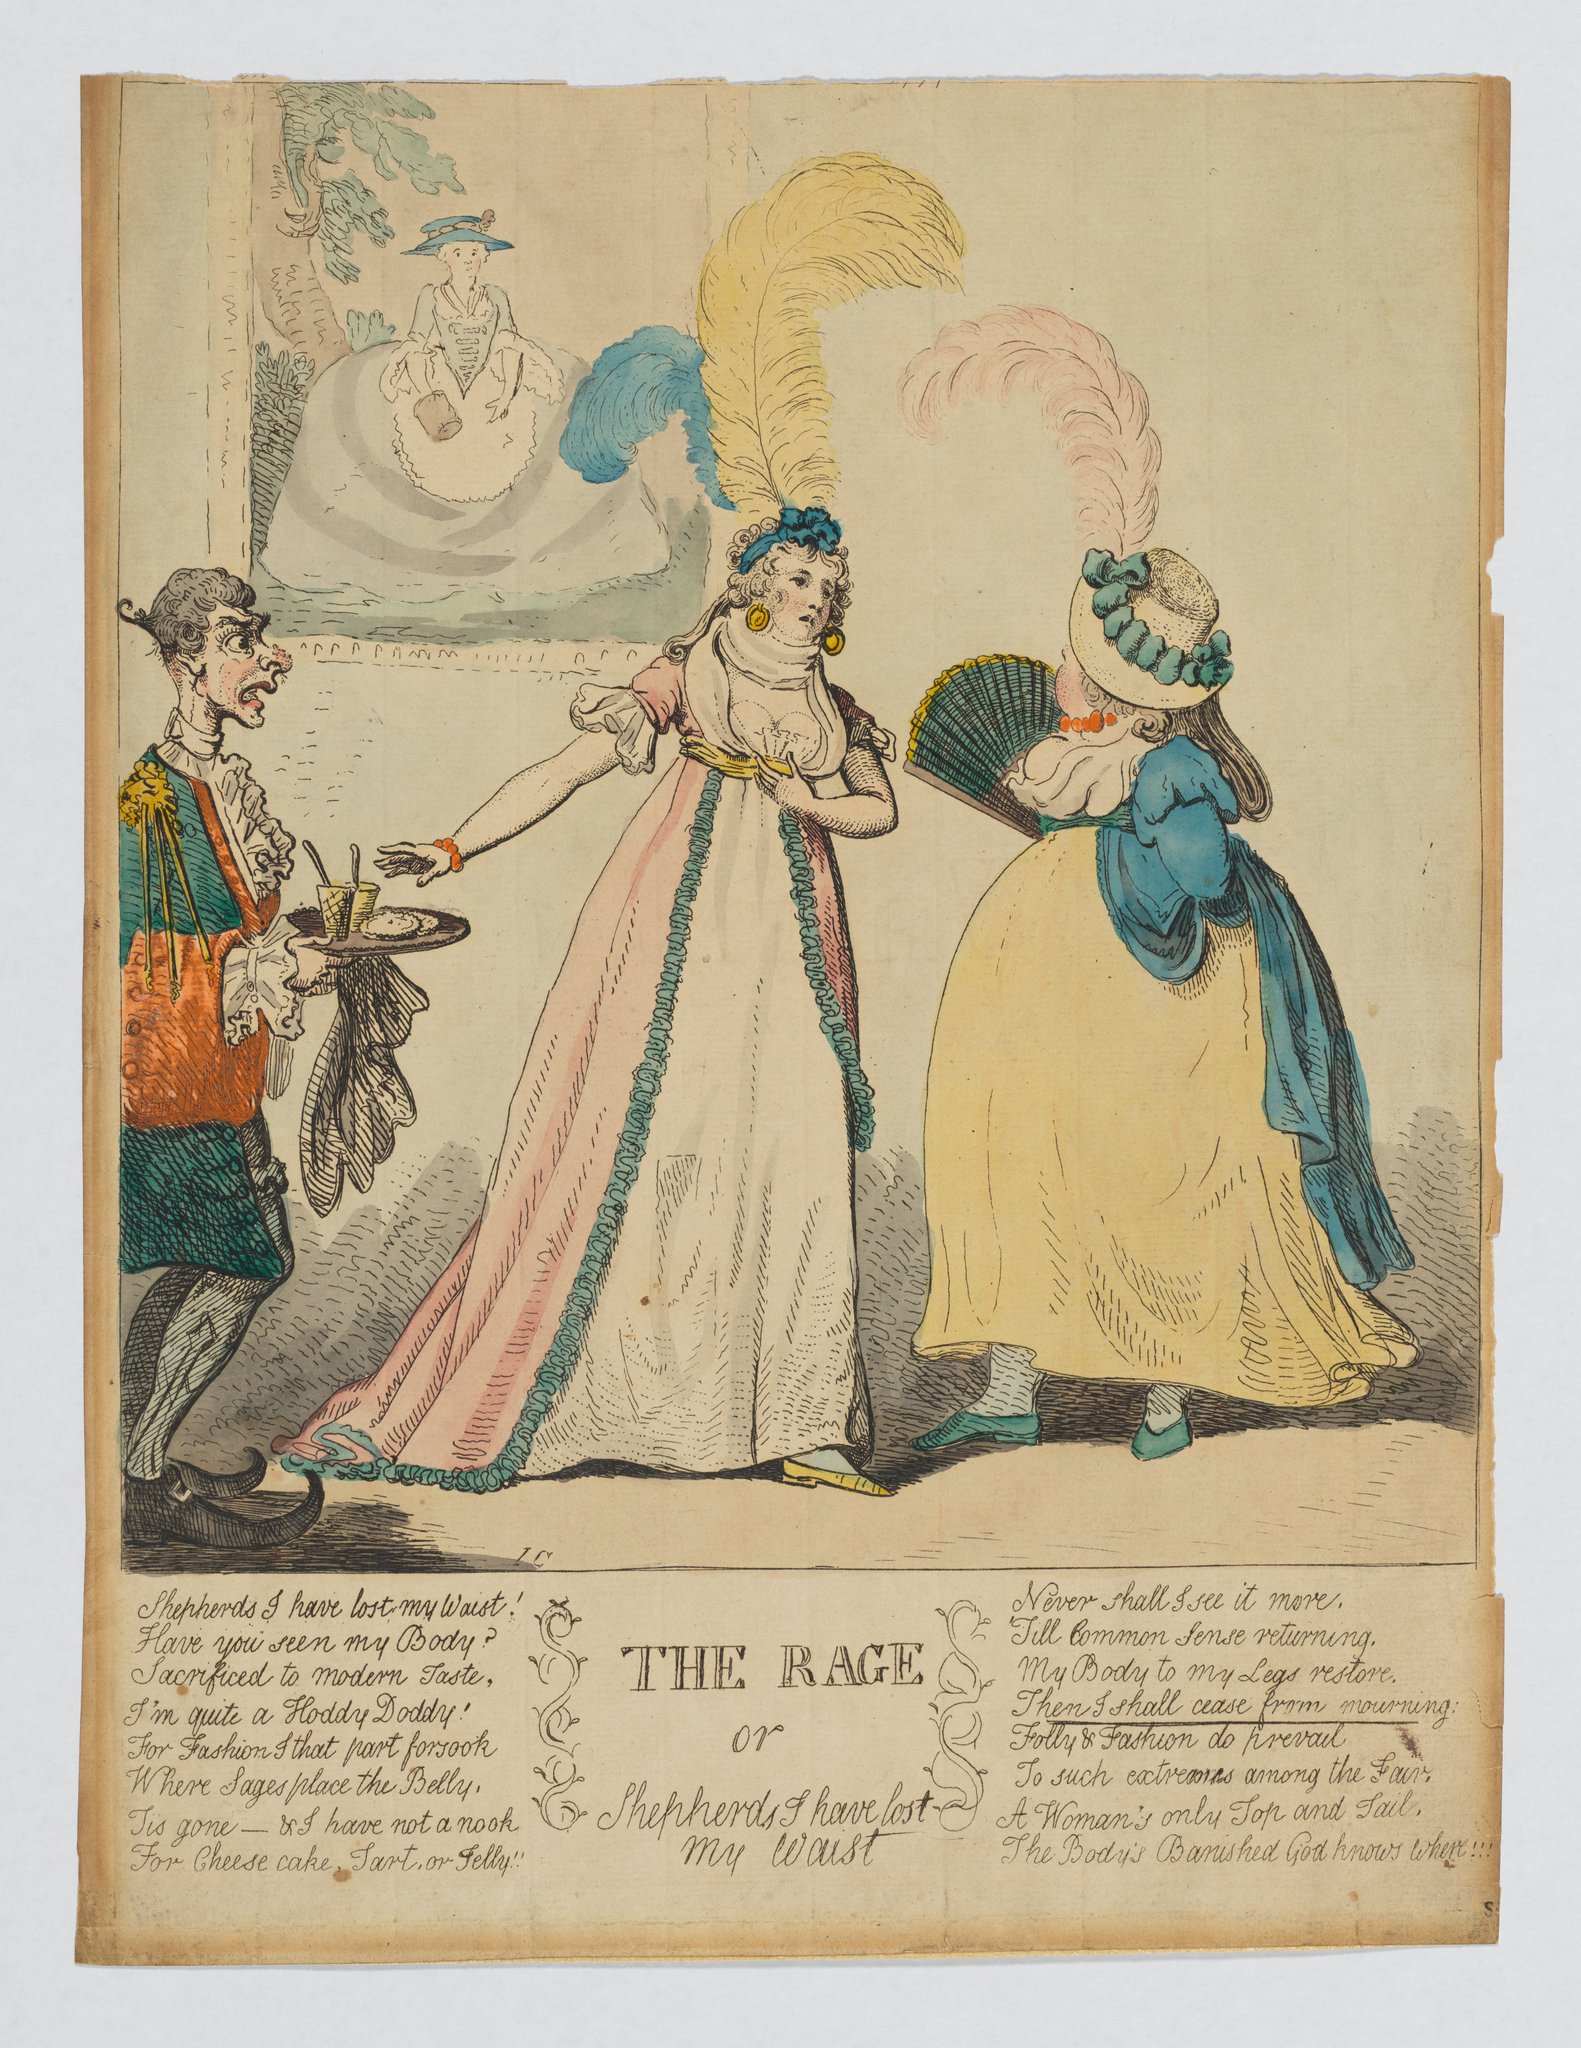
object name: print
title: The Rage, or Shepherds I have lost My Waist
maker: isaac cruikshank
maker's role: artist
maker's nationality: british, scottish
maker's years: 1764-1811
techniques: etching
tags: satire,men,women,servants